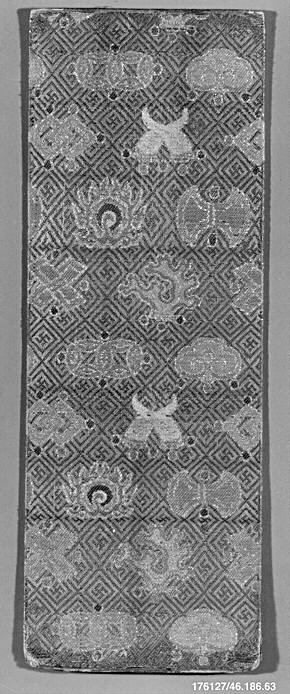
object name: sutra cover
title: Sutra Cover with Auspicious Symbols on Diaper Ground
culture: chinese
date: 1501-1600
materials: metal thread, silk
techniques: lampas